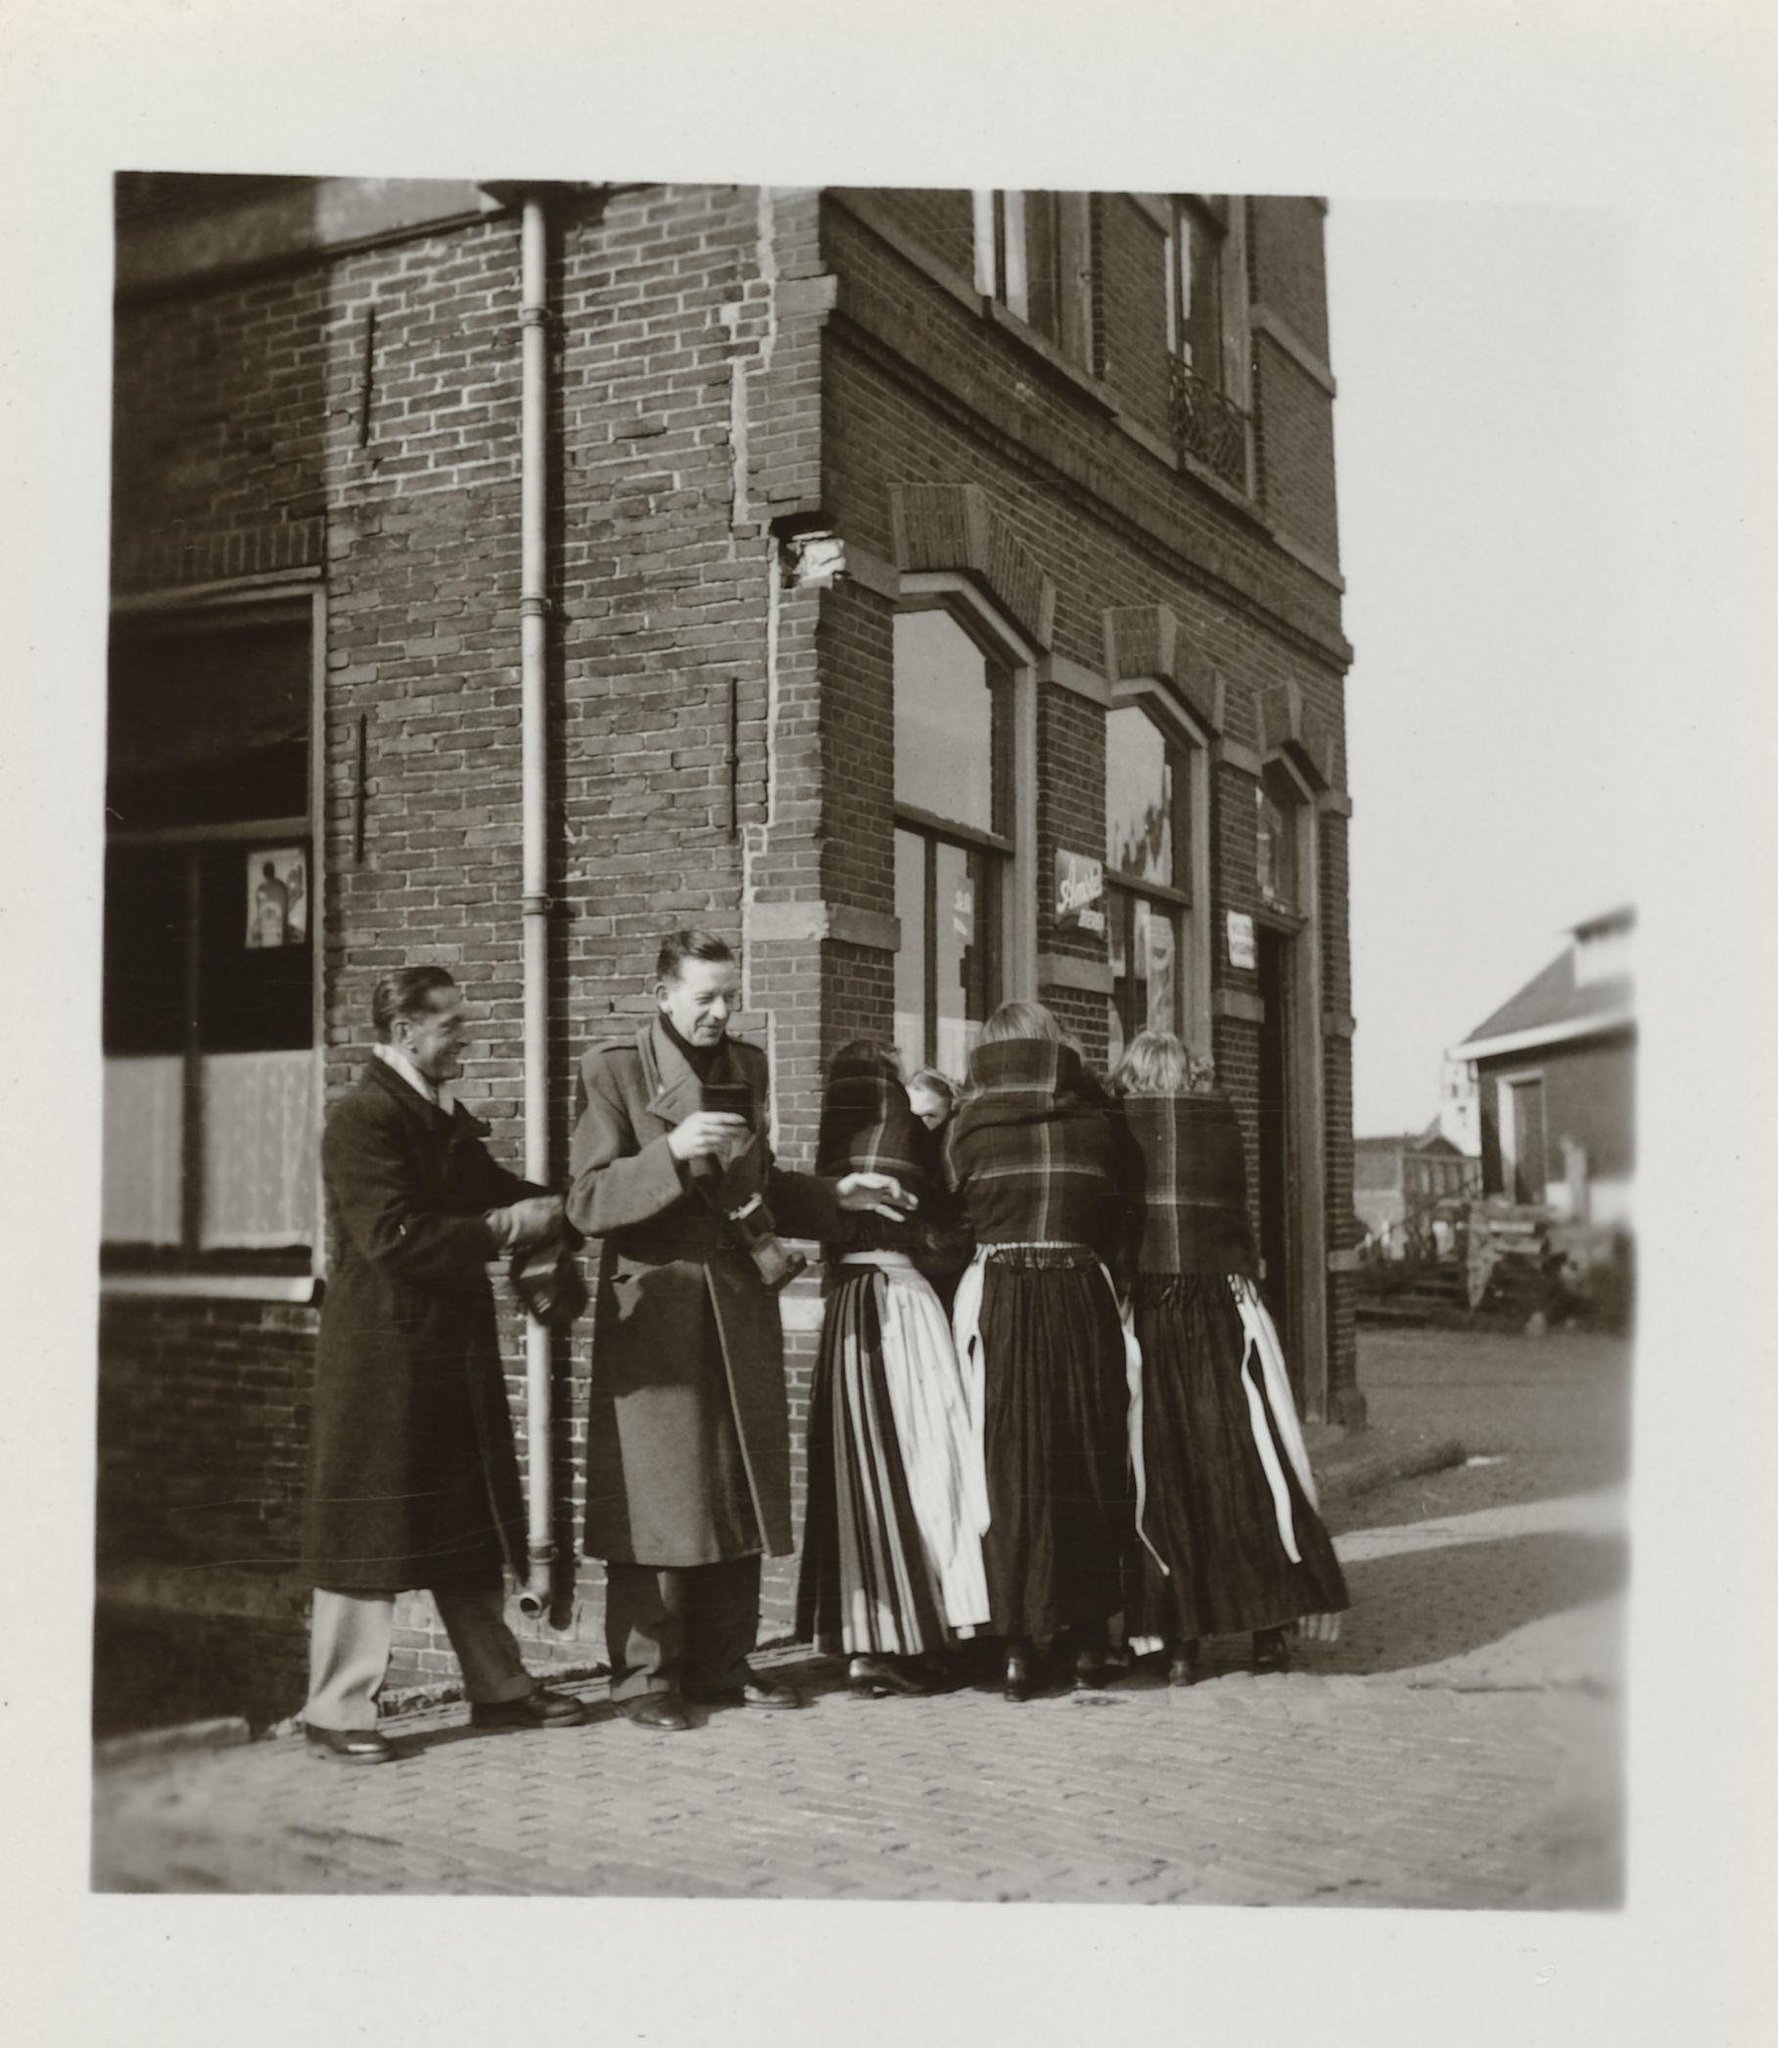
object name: photograph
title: Gideon Elon, de derde echtgenoot van Isabel Wachenheimer, in een Nederlandse stad naast drie vrouwen in Nederlandse klederdracht en een onbekende man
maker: Anonymous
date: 1956-1970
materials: photographic support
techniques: gelatin silver print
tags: gideon elon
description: Gideon Elon (eerste van links), de derde echtgenoot van Isabel Wachenheimer, in een Nederlandse stad naast drie vrouwen in Nederlandse klederdracht en een onbekende man.